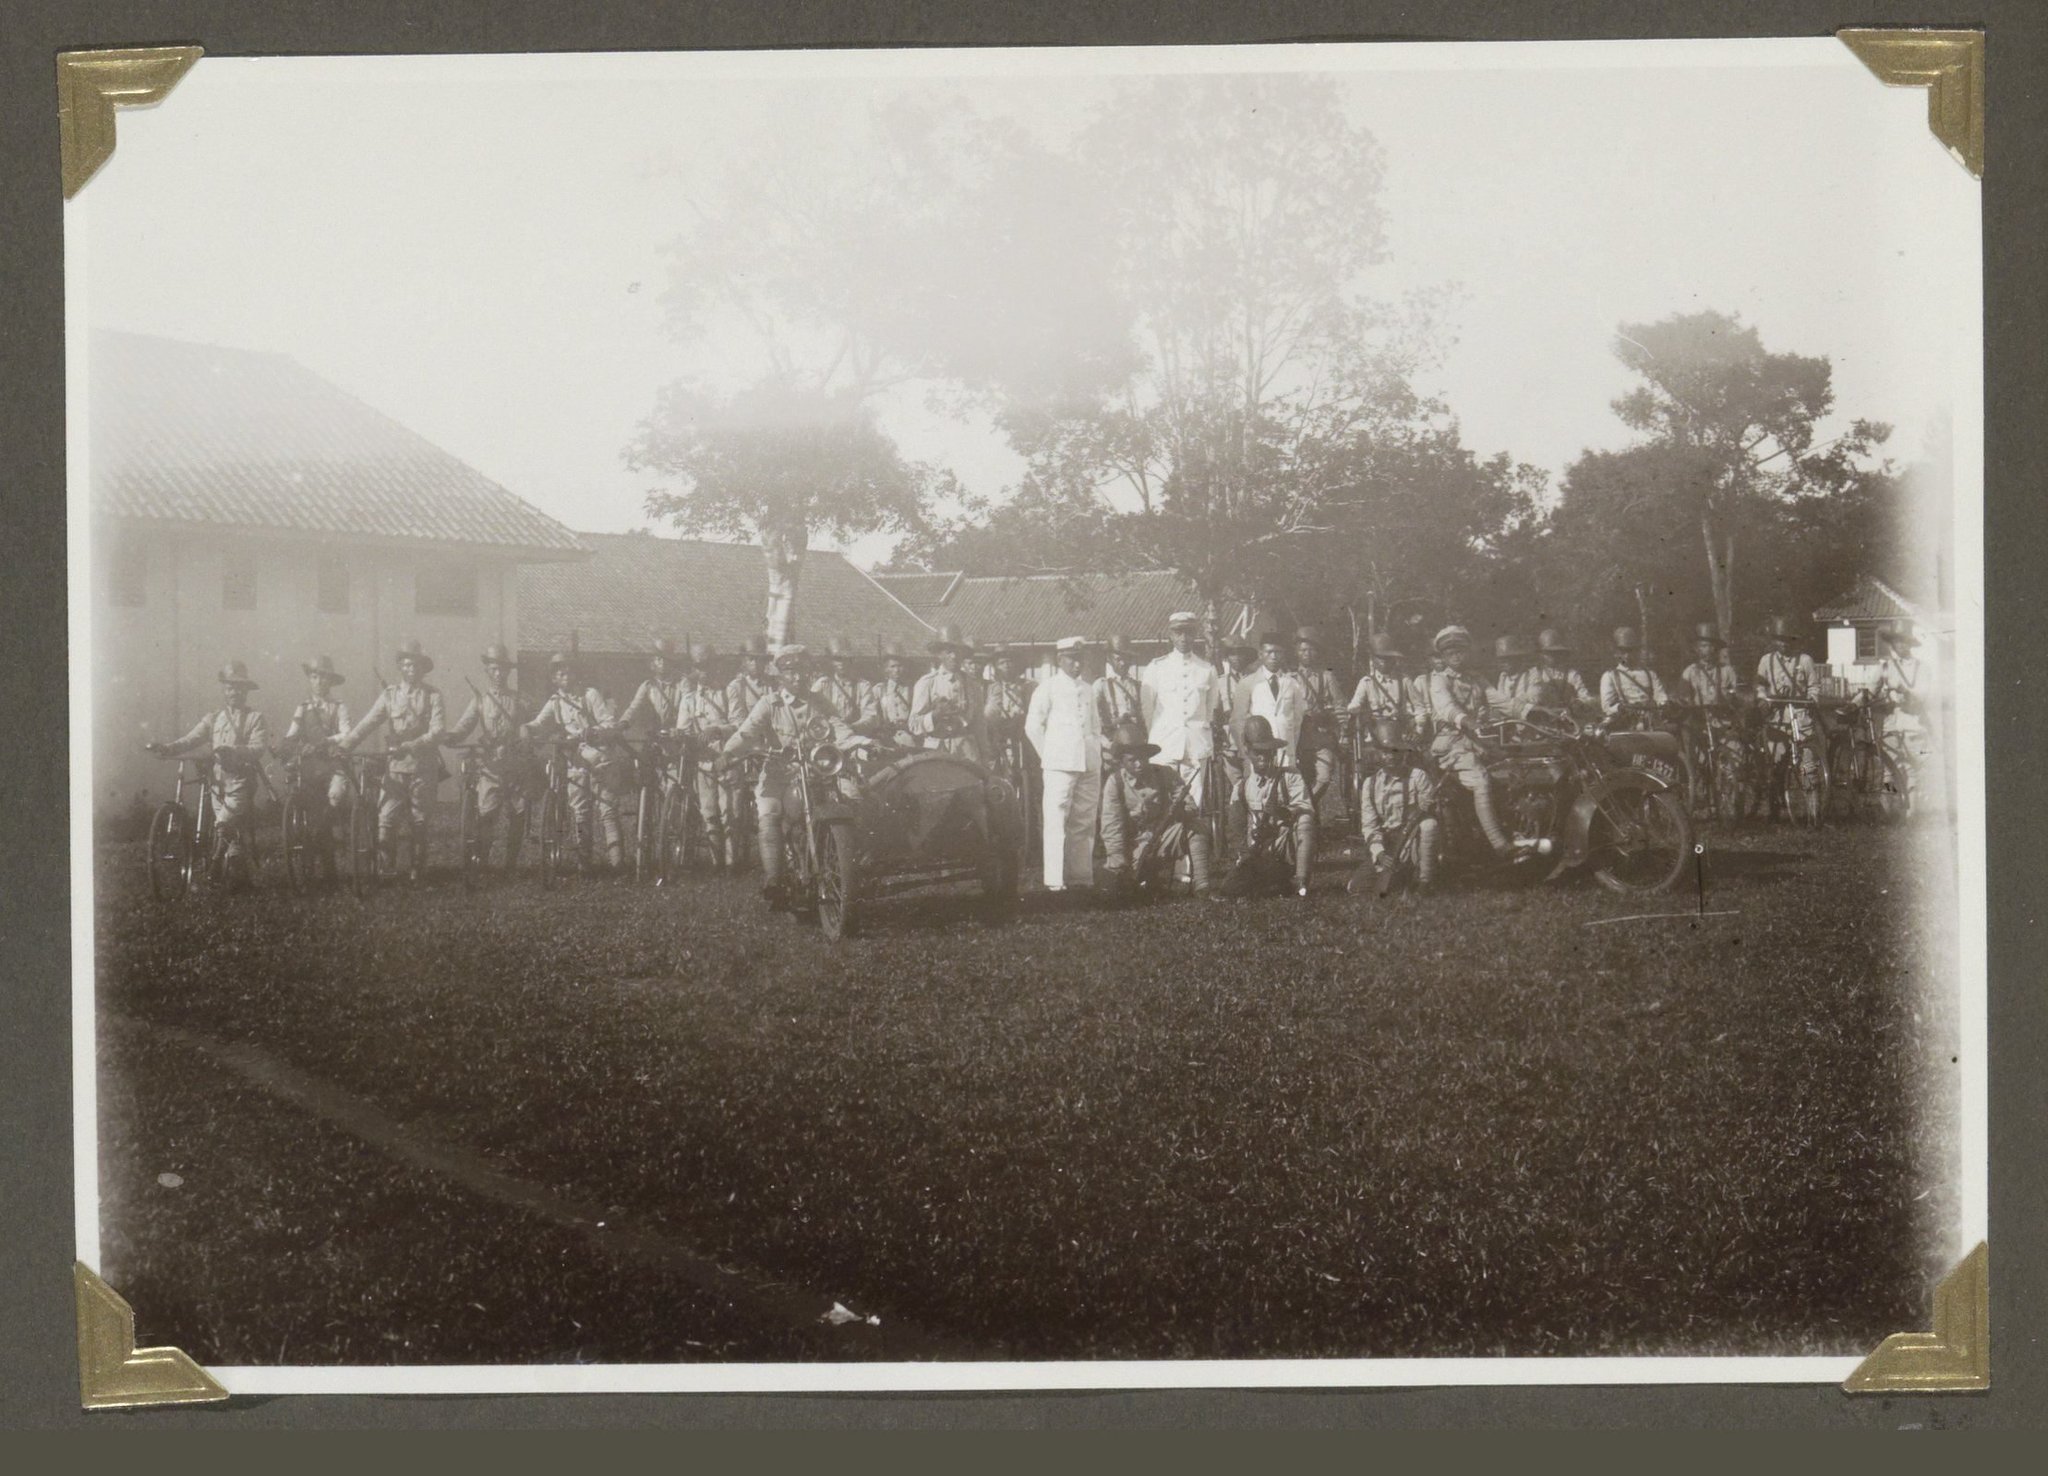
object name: photograph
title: Groepsportret van de veldpolitie te Menggala (Zuid-Sumatra)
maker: Anonymous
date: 1932-1933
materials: photographic support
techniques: gelatin silver print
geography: lampung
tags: police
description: Onderdeel van Herinneringsalbum voor F.J. Junius, vertrekkend resident van Lampong (Zuid-Sumatra).